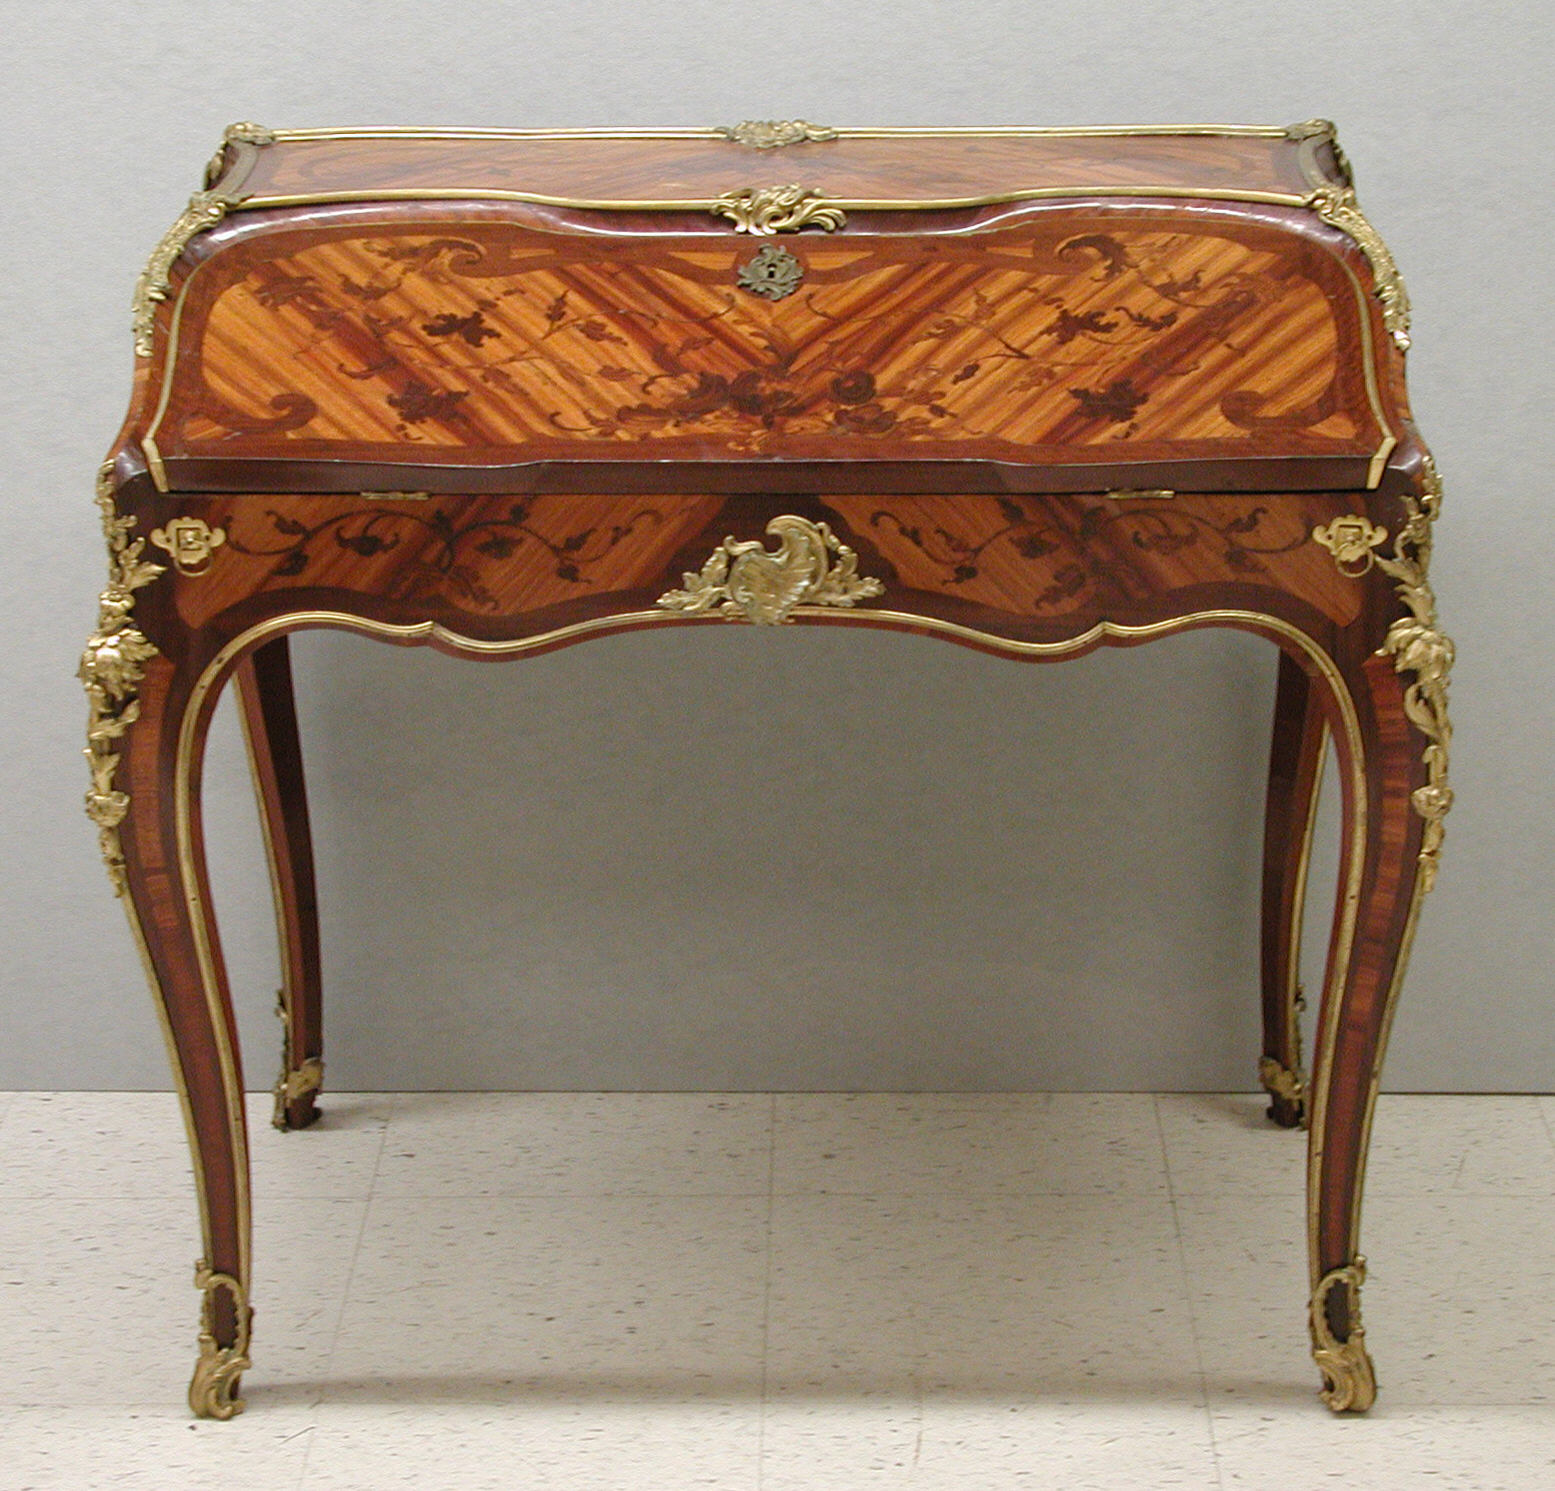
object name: slant top desk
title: Slant-top desk (secrétaire en pente)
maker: bernard ii van risenburgh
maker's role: maker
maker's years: 1696-1767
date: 1745-1749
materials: gilt bronze, leather, wood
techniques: cutting, veneering